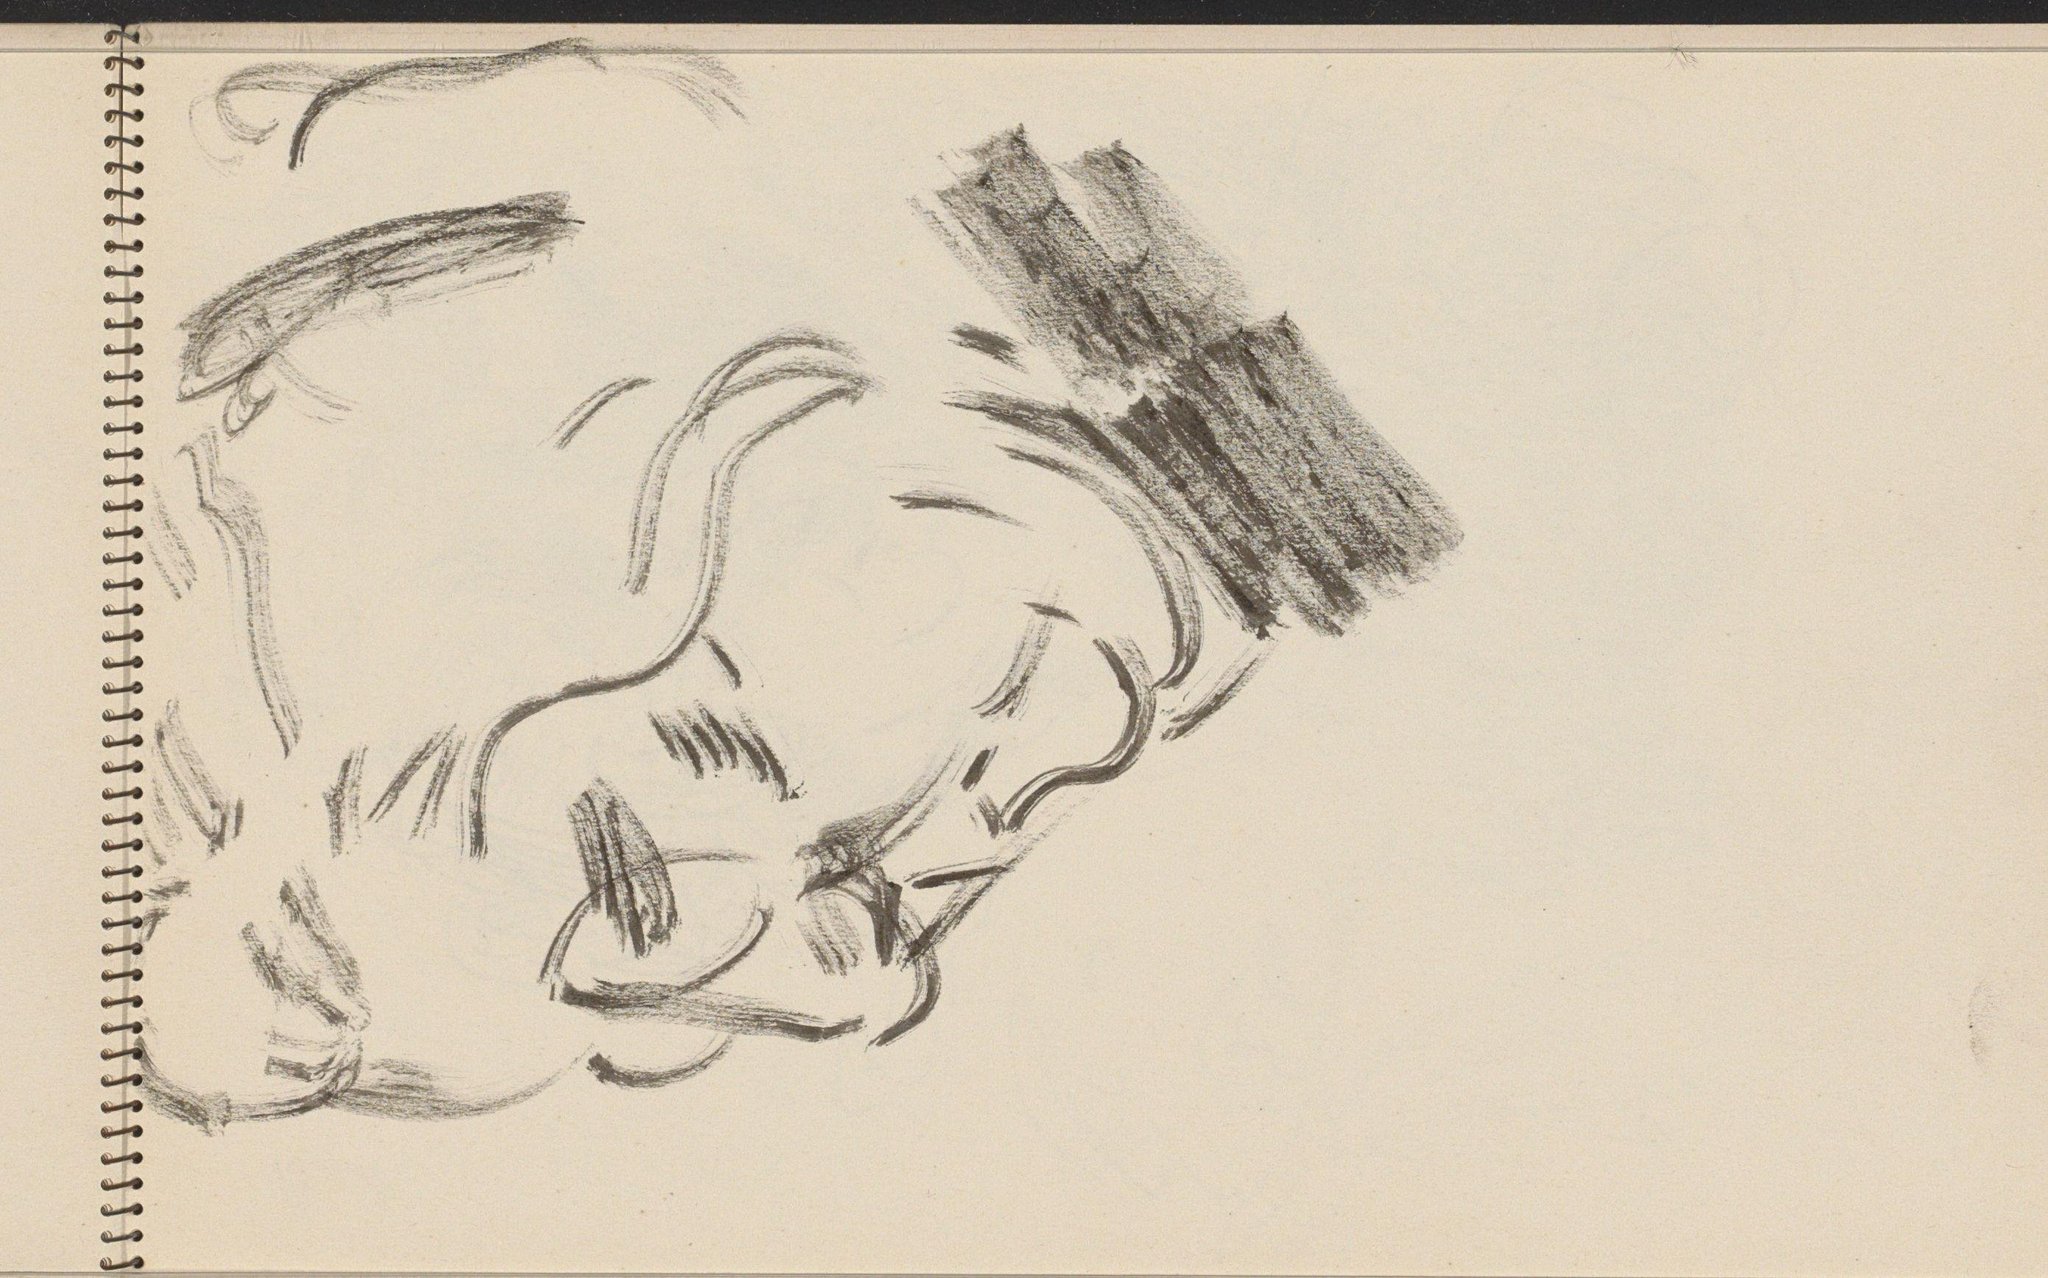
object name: sketchbook leaf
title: Portretkop van Joanna Lion Cachet-Cordes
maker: carel adolph lion cachet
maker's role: draughtsman, print maker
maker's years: 1864-1945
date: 1935-1940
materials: ink, paper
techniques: brush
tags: head (human) (+ female (human being) (not to be used where -aa- is prescribed))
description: Blad 18 recto uit een schetsboek met 25 bladen.